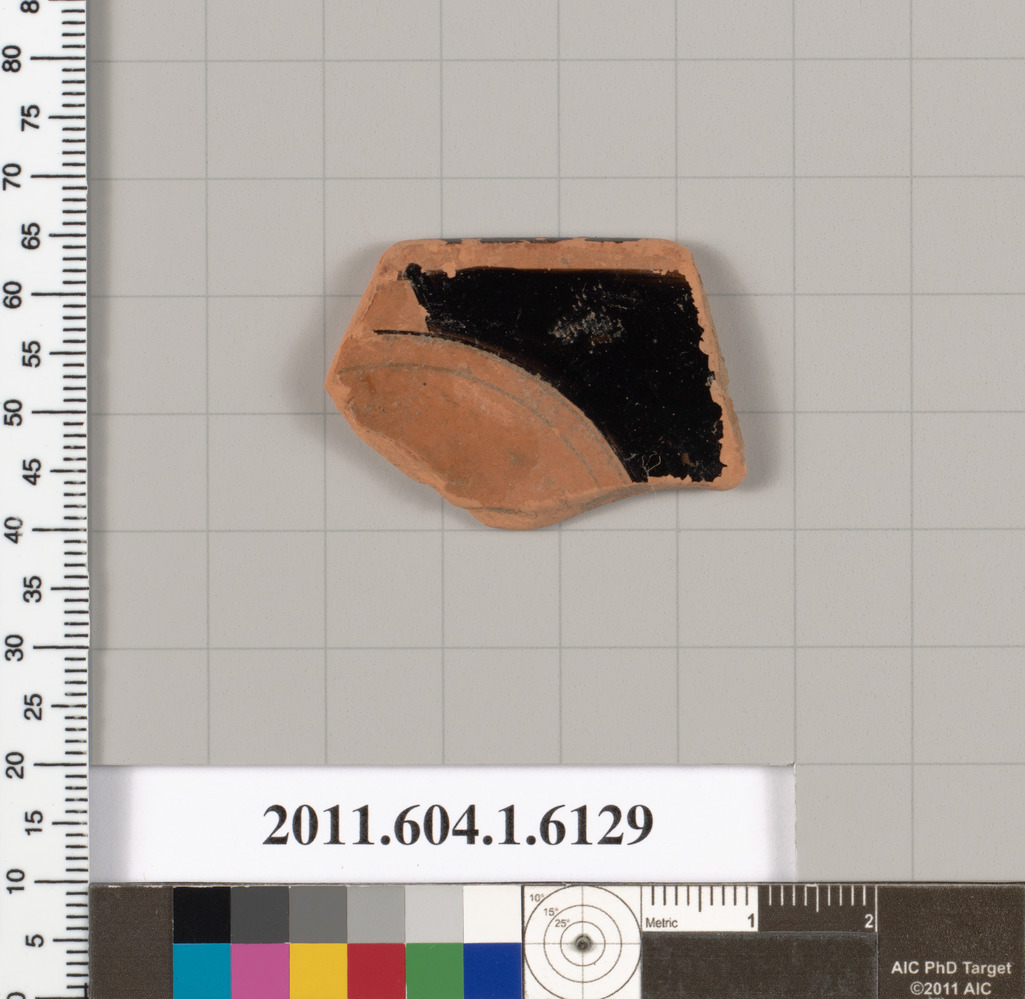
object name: kylix fragment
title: Terracotta rim fragment of a kylix (drinking cup)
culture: greek, attic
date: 520-500 BCE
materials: terracotta